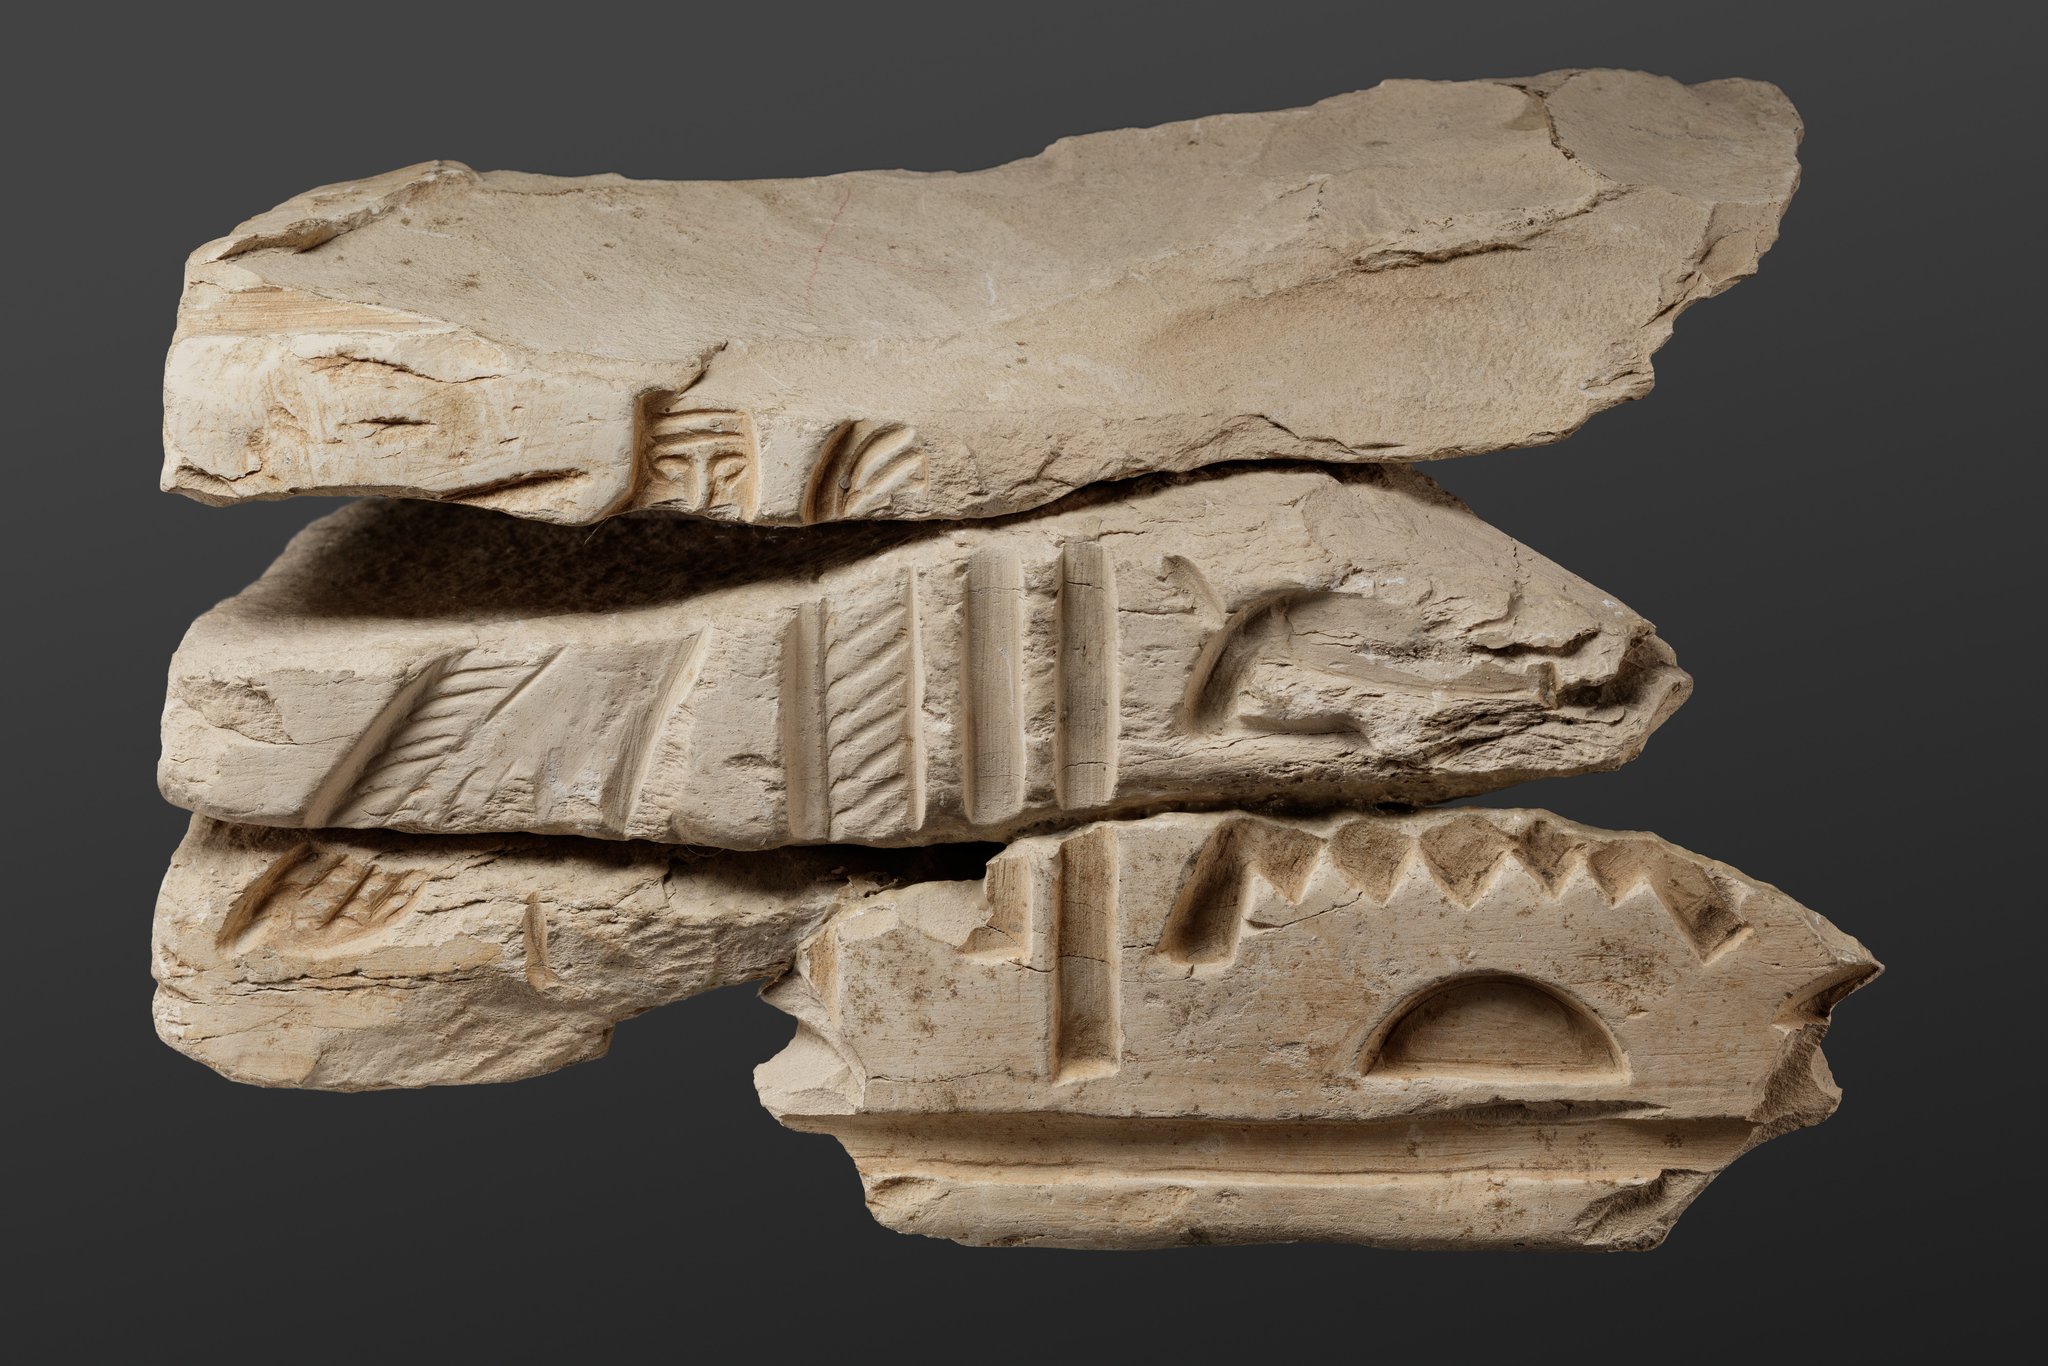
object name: relief fragment 47, tomb of mereri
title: Relief fragment possibly from the tomb of Mereri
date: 2100-2090 BCE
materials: stone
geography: egypt